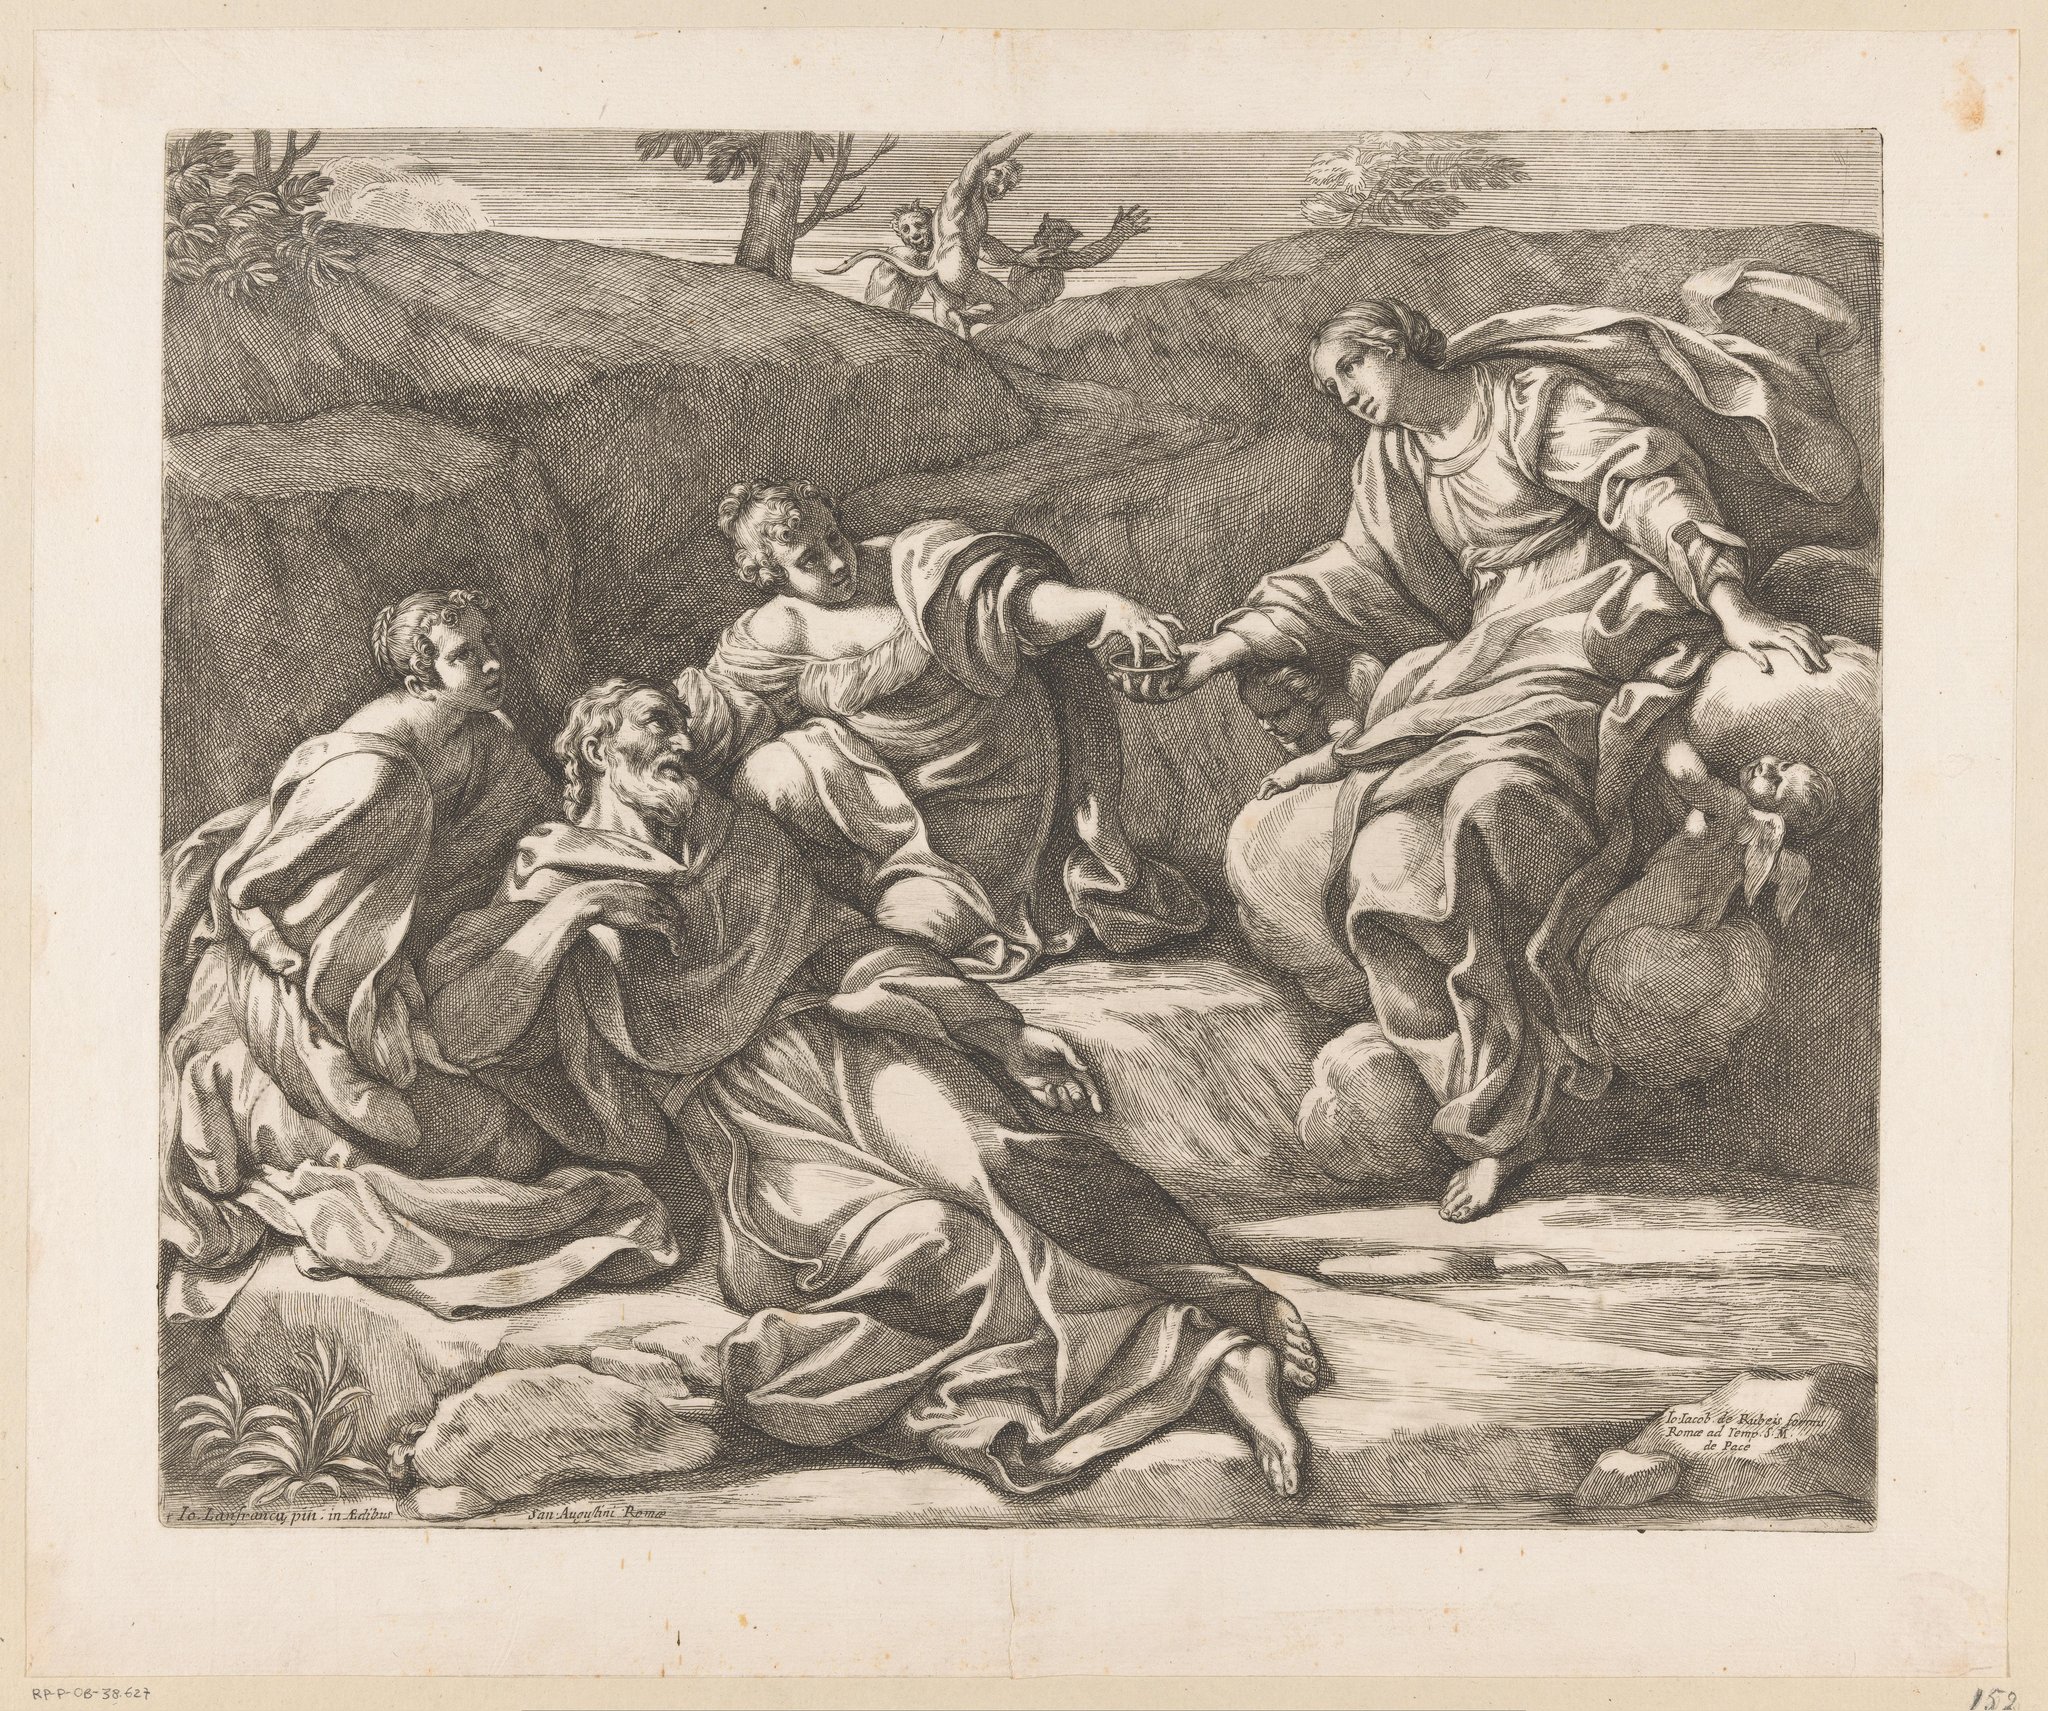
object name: print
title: Maria verschijnt aan Willem van Rievaulx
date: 1632-1682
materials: paper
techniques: etching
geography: rome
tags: landscapes, the virgin mary, devil(s) and demons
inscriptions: collector's mark: Lugt 240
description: Maria verschijnt aan de heilige Willem van Rievaulx samen met twee andere vrouwelijke figuren. Op de achtergrond de demonen waar Willem van Rievaulx mee vocht.